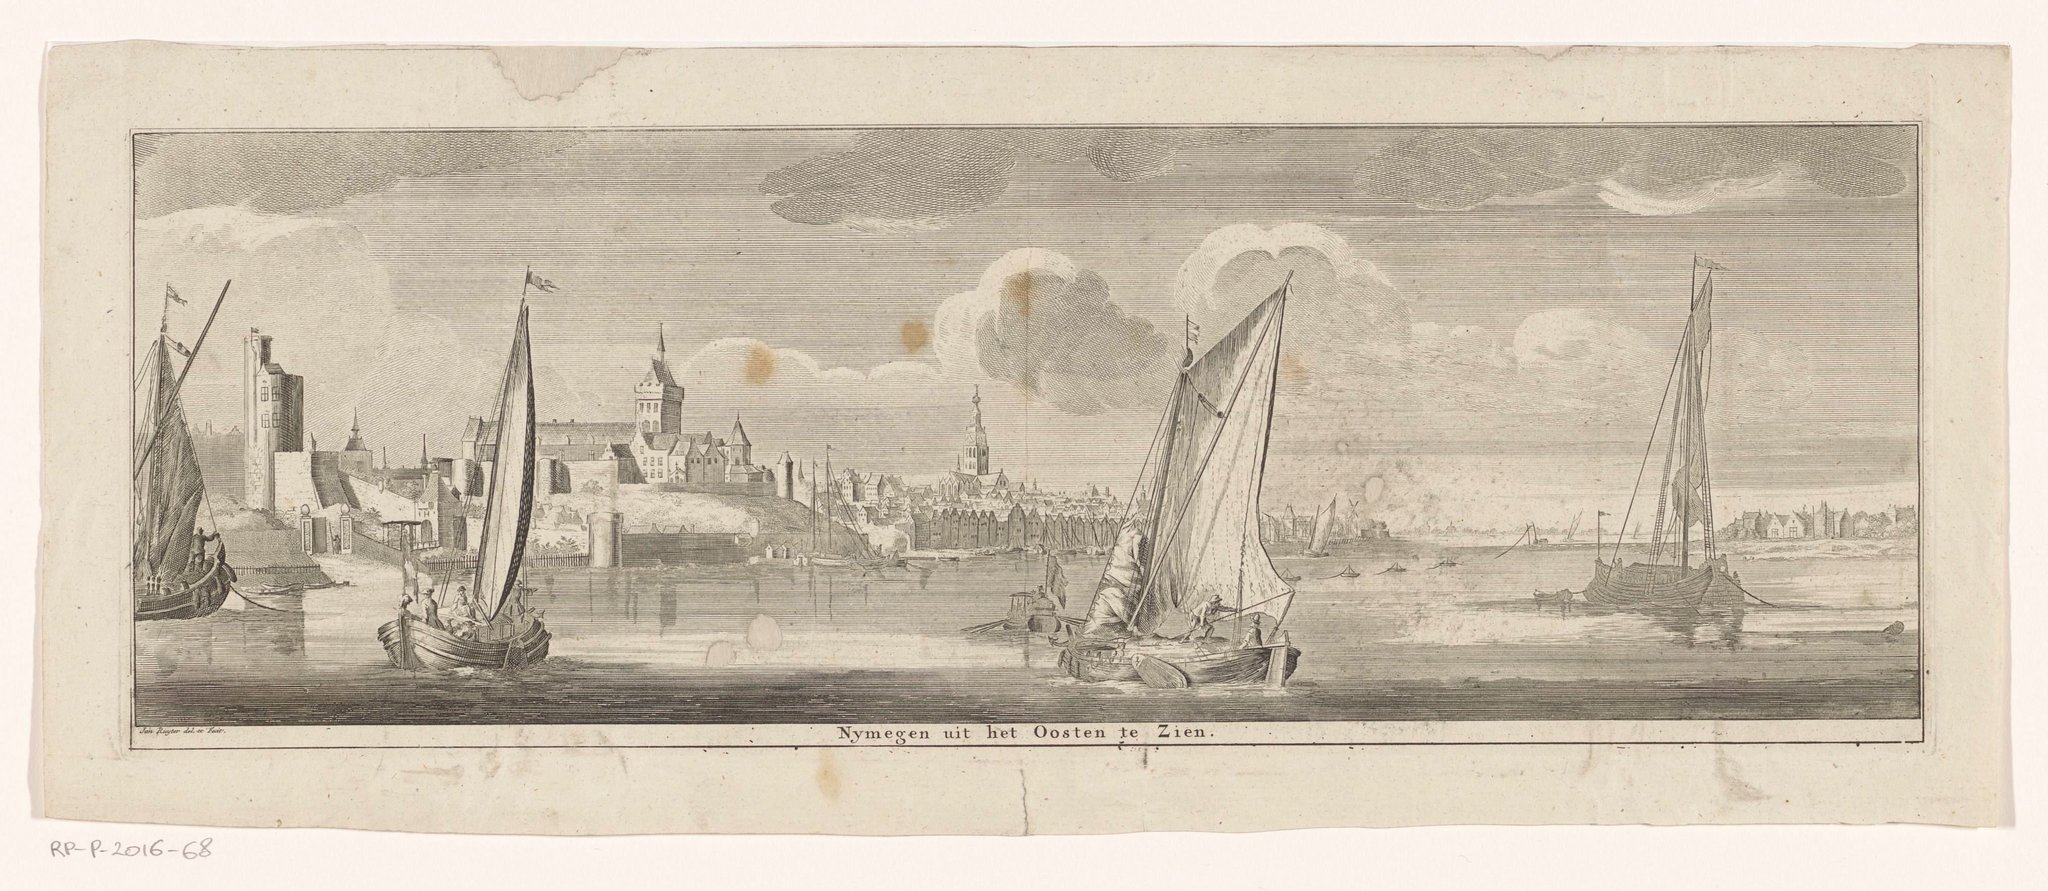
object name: print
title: Nymegen uit het oosten te zien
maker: johannes de ruijter (1688-1744)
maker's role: print maker, publisher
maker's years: 1688-1744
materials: paper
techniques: engraving, etching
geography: amsterdam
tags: sailing-ship, sailing-boat, prospect of city, town panorama, silhouette of city, nijmegen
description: Gezicht over de rivier de Waal op de stad Nijmegen, met het Valkhof en op de achtergrond de Sint-Stevenskerk. Op de voorgrond diverse zeilschepen.